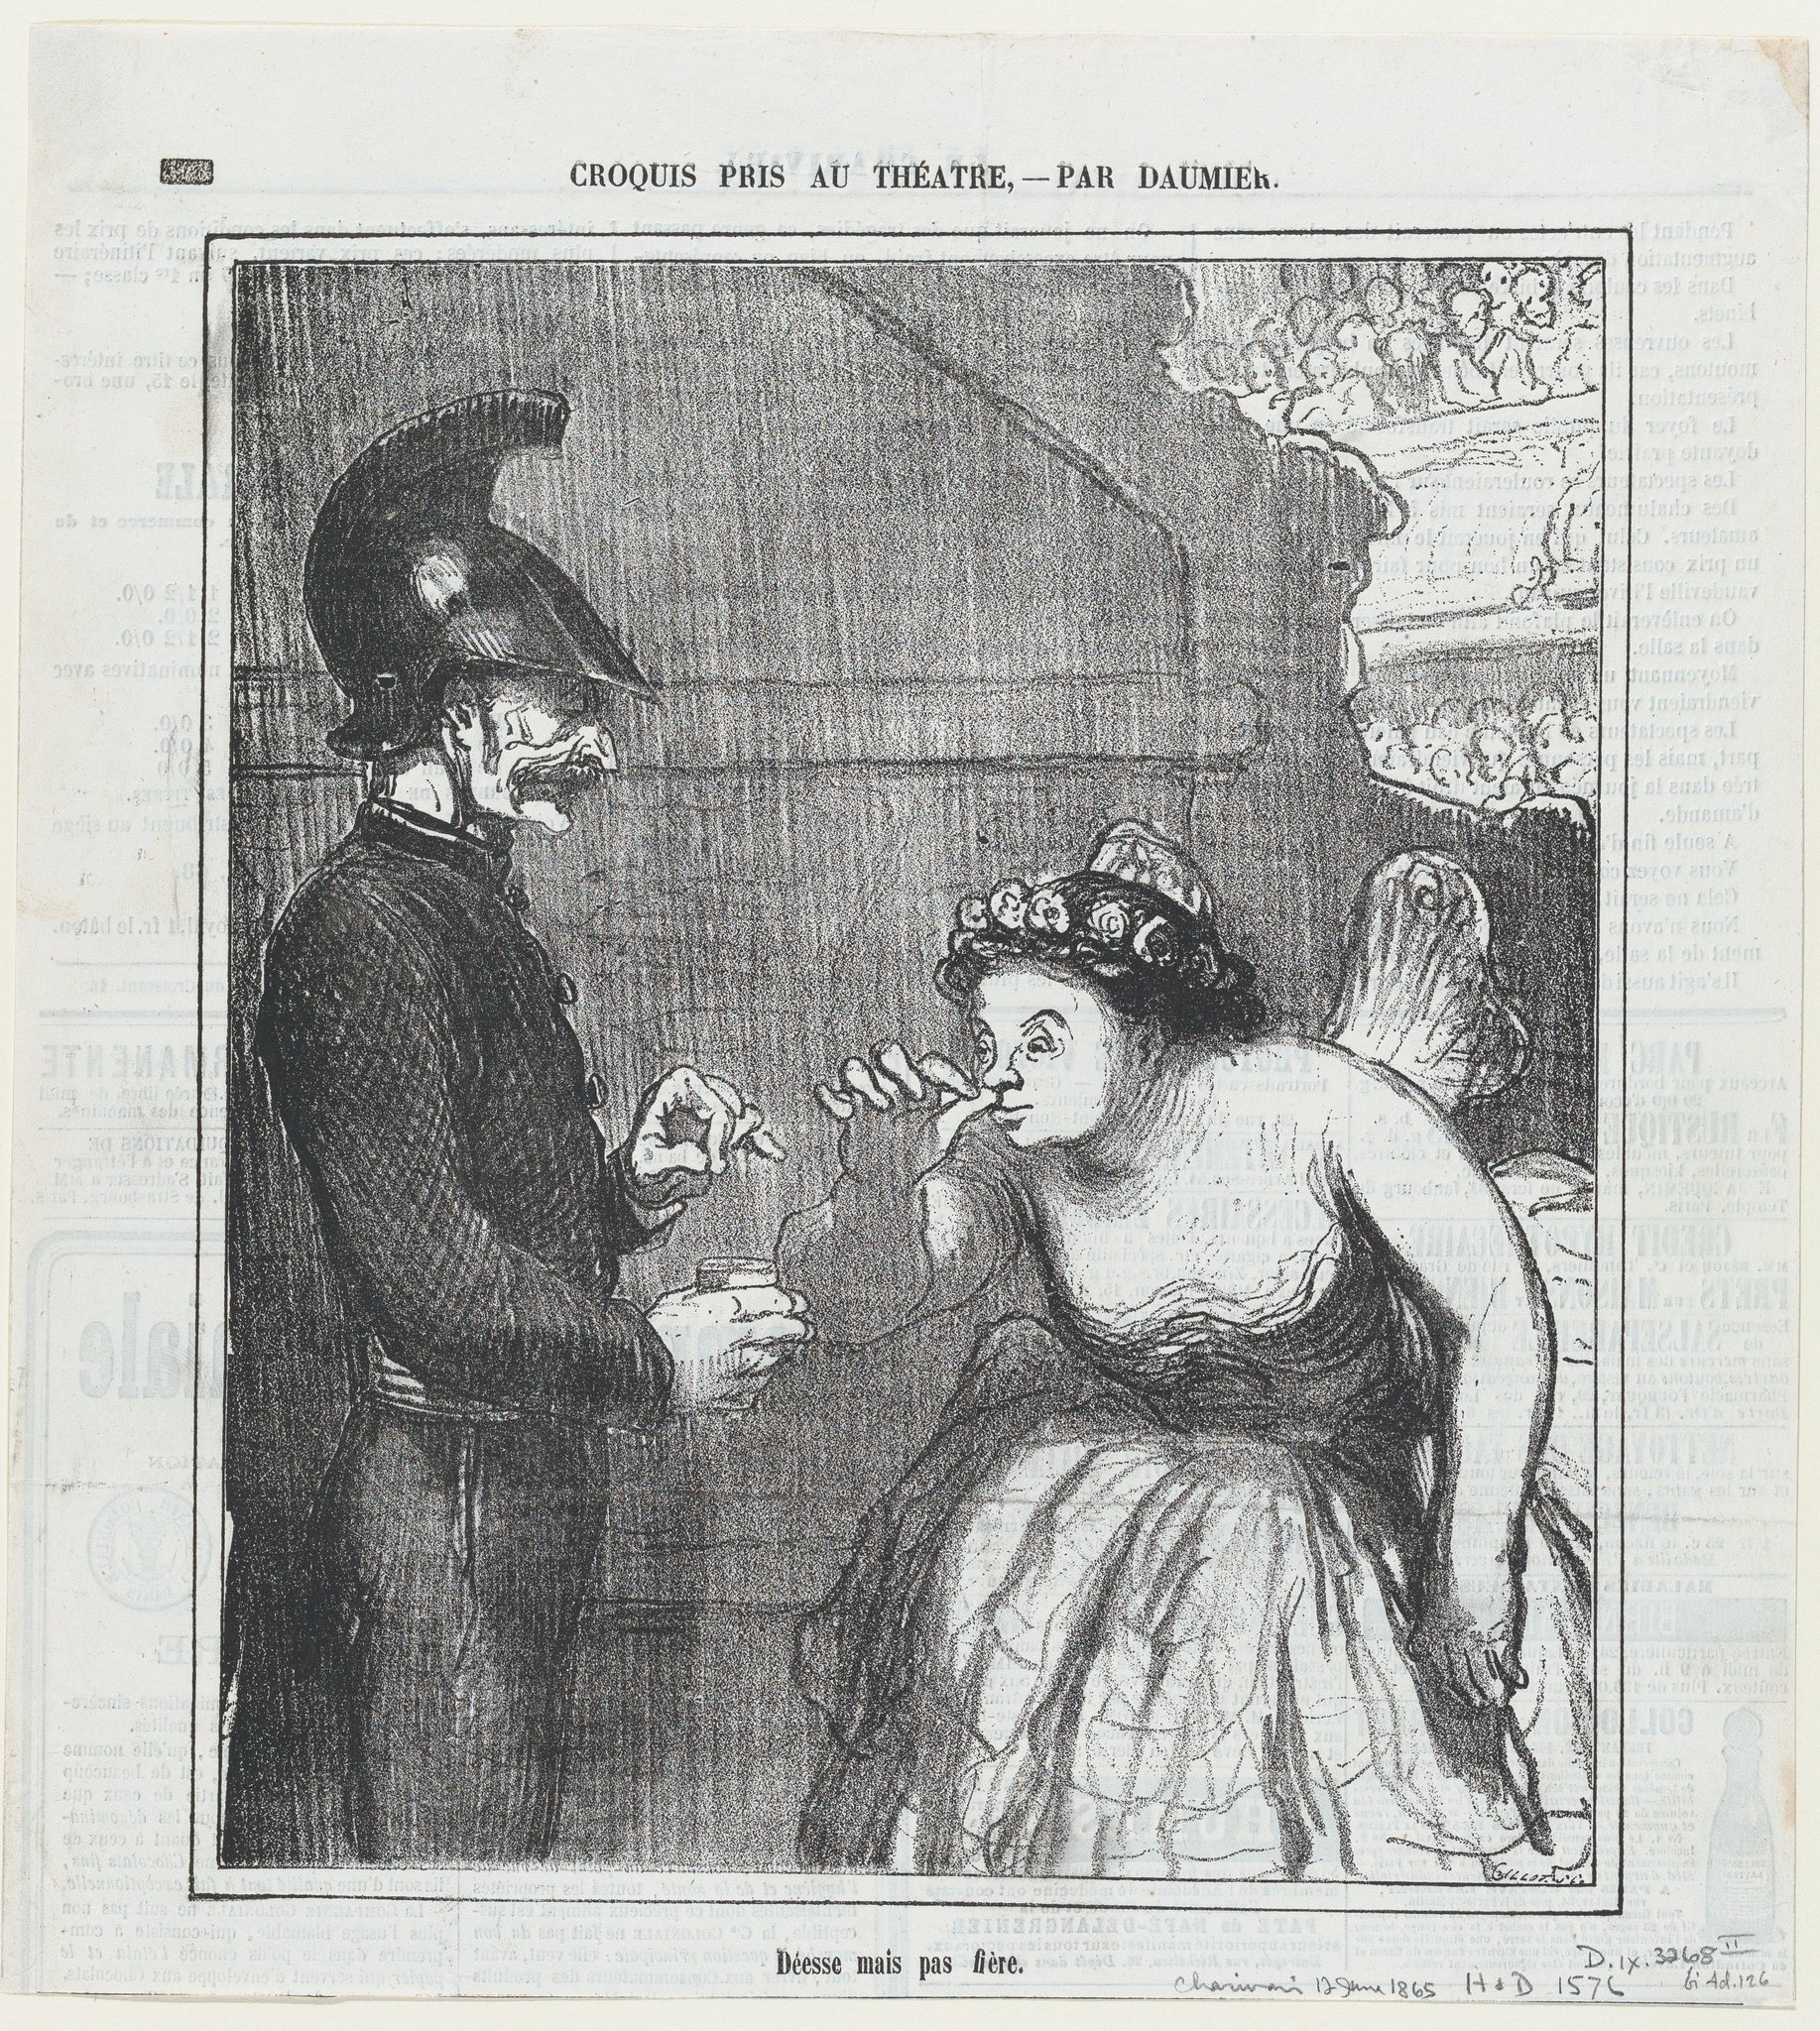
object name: print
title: A goddess, but not proud at all, from 'Theater sketches,' published in Le Charivari, June 12, 1865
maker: honoré daumier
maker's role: artist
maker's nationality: french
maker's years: 1808-1879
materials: paper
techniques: lithograph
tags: men,goddess